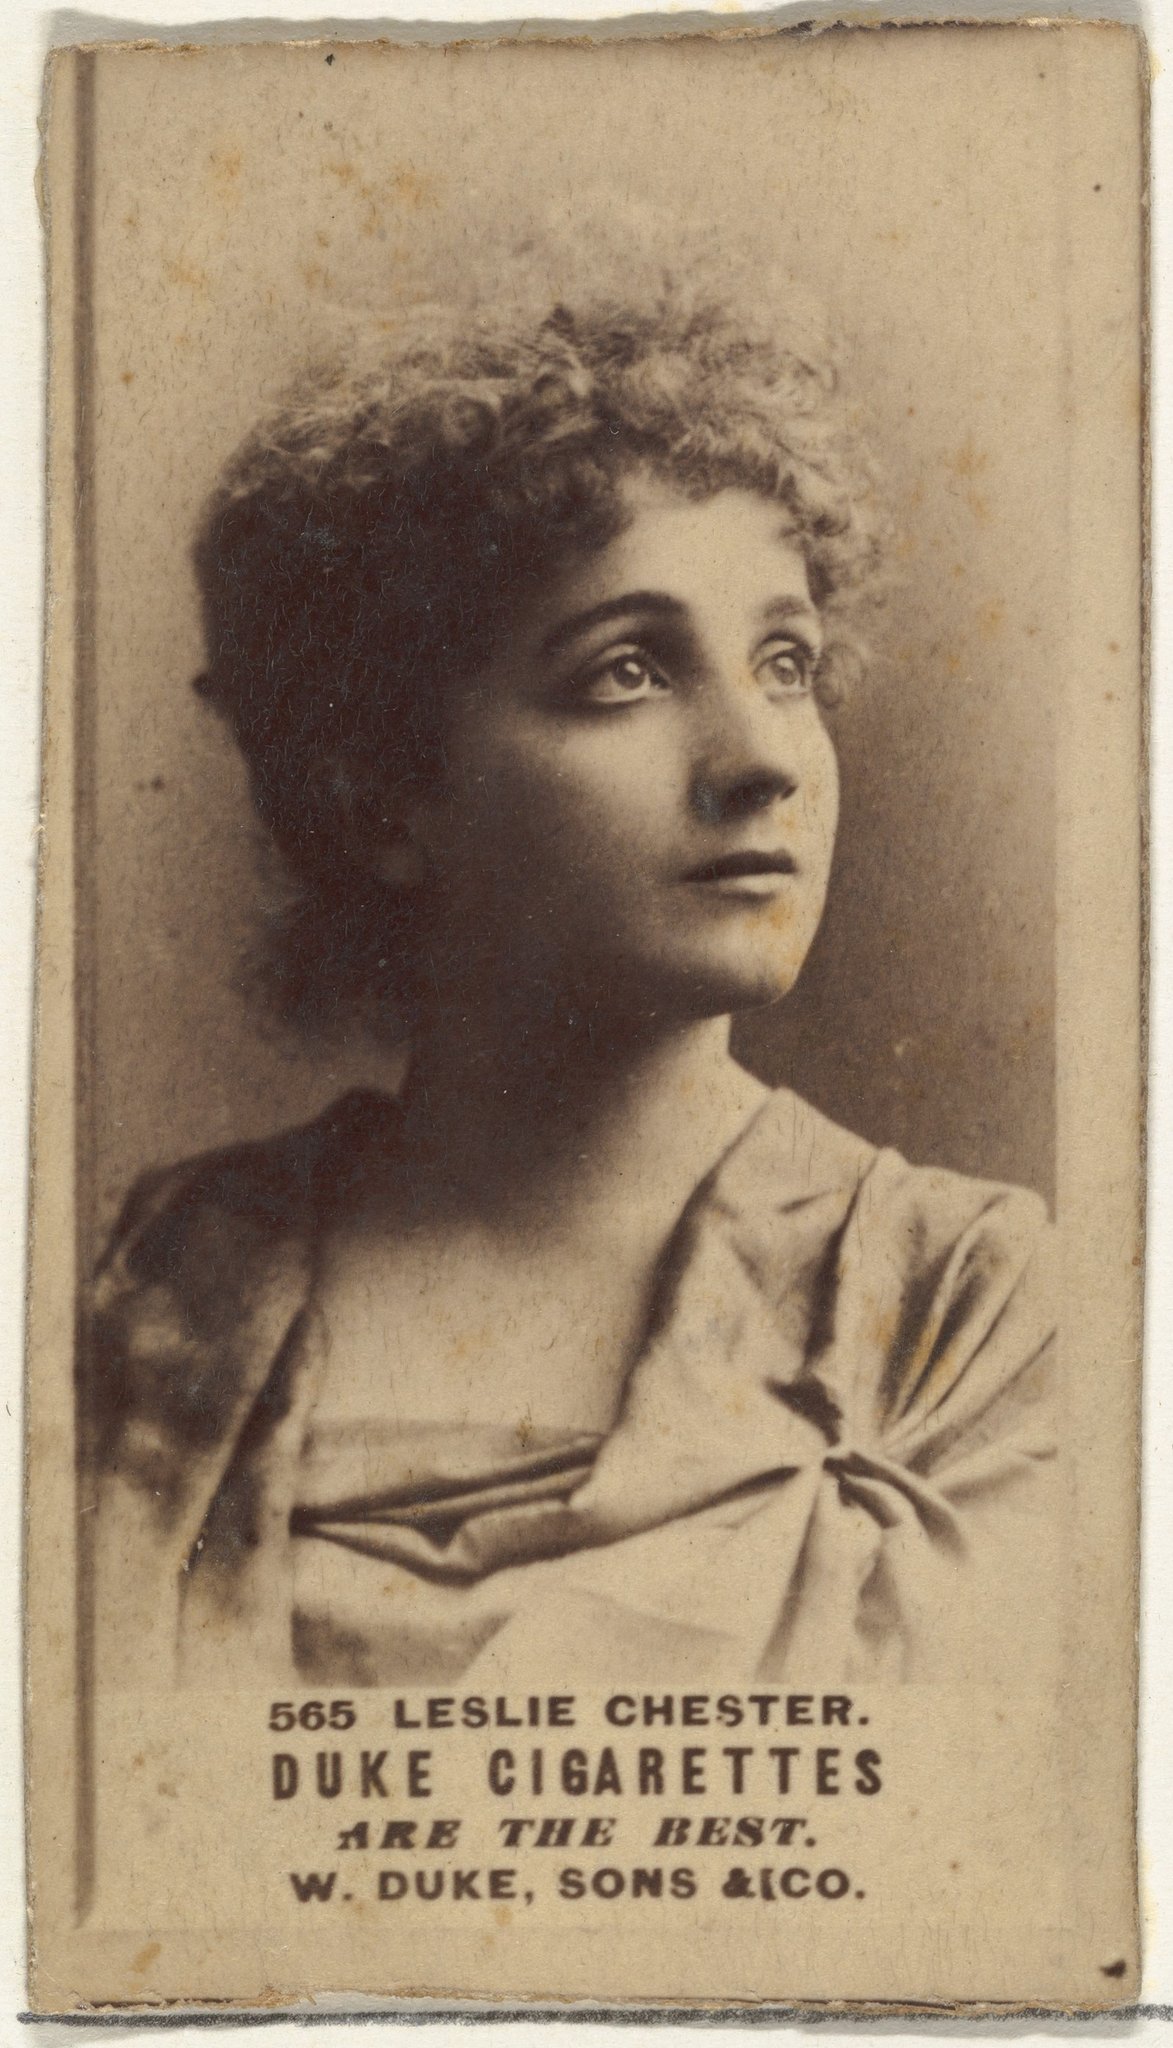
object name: photograph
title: Card Number 565, Leslie Chester, from the Actors and Actresses series (N145-7) issued by Duke Sons & Co. to promote Duke Cigarettes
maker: w. duke, sons & co.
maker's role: publisher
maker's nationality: american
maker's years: 1870-1920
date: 1880-1889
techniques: albumen silver print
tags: portraits,women,actresses